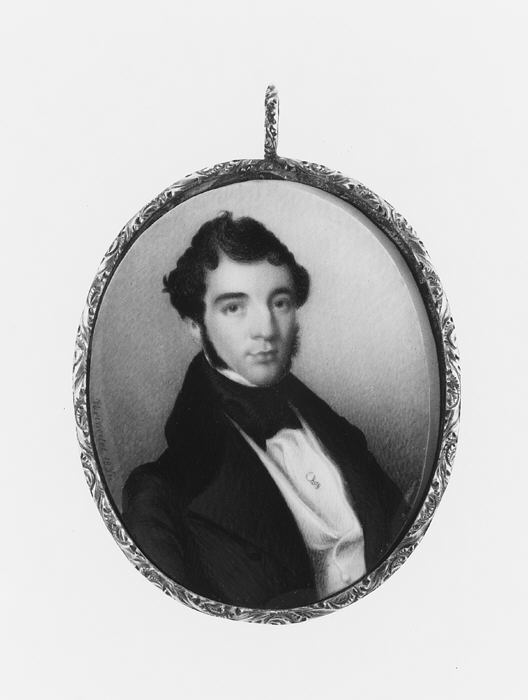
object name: painting, miniature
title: Portrait of a Gentleman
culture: american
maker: carl weinedel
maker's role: artist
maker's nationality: american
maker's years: 1795-1845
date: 1837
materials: ivory, watercolor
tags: men,portraits